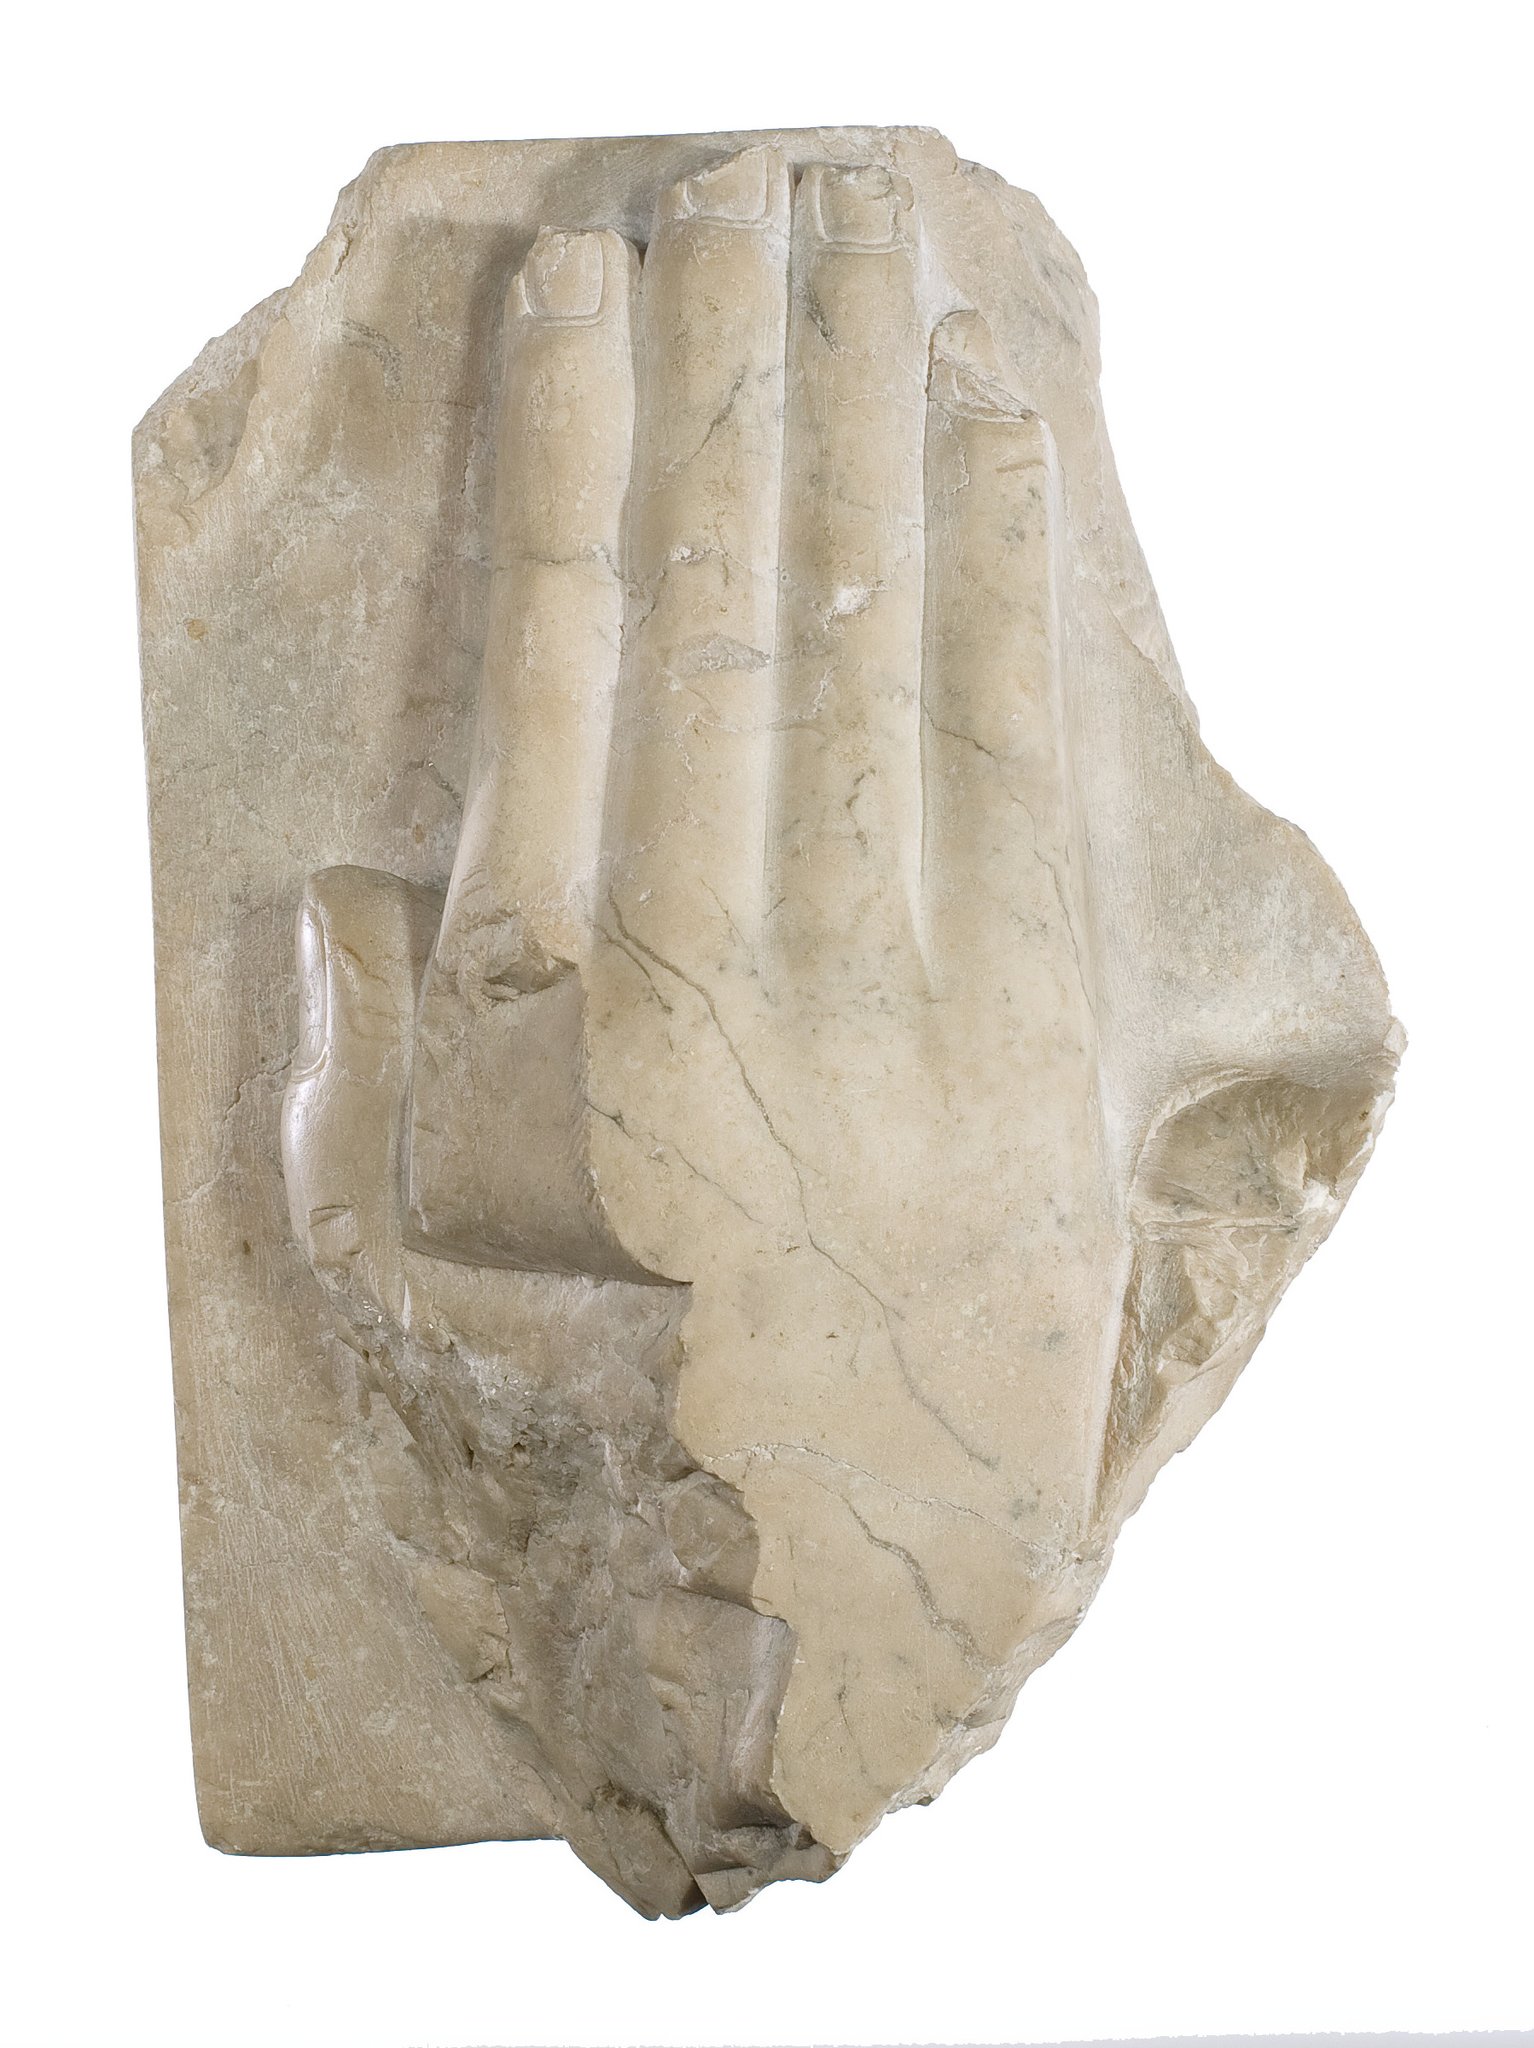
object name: offering table with hand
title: Offering table with hand beneath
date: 1353-1323 BCE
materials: limestone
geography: middle egypt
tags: hands